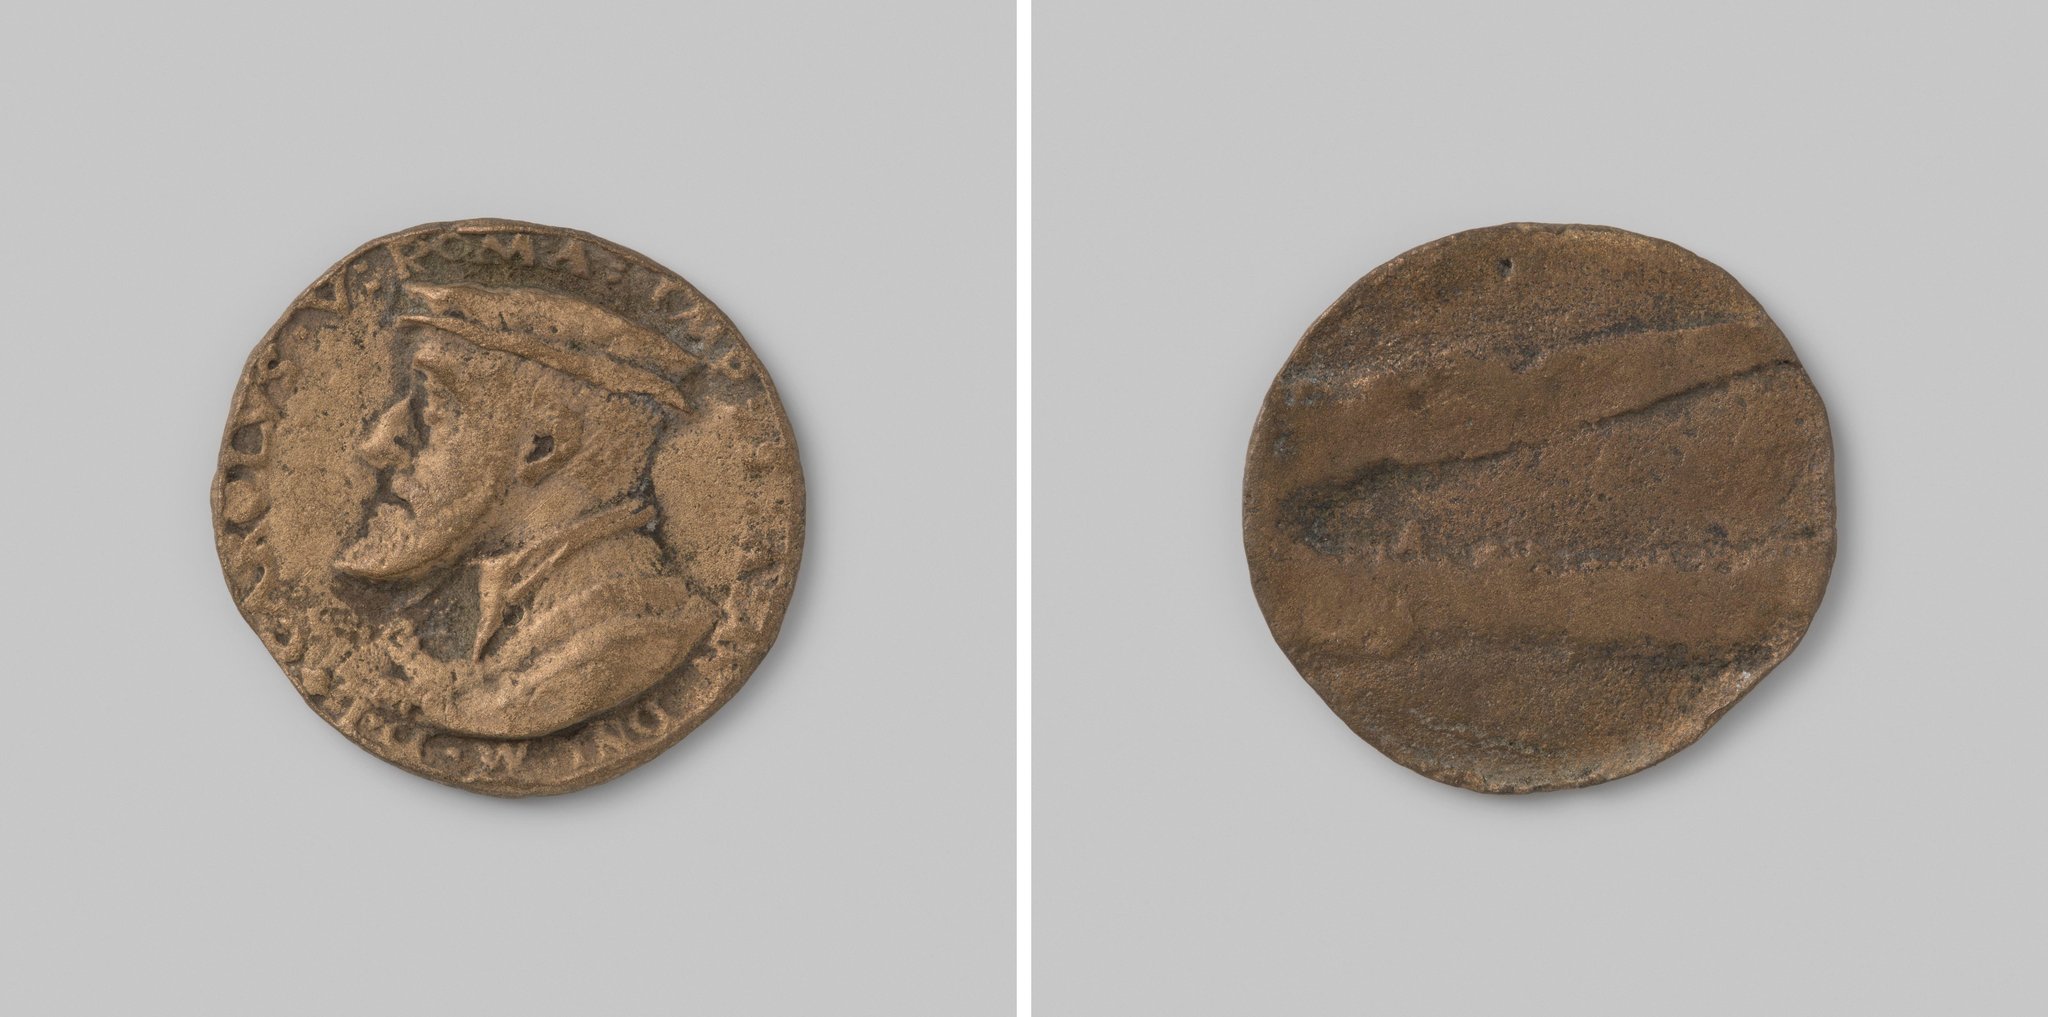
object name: history medal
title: Karel V, Duits keizer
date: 1550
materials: bronze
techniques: casting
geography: augsburg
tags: ghent, charles v (holy roman emperor and king of spain)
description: Eenzijdige bronzen penning. Voorzijde: borststuk man binnen omschrift. Keerzijde: blanco